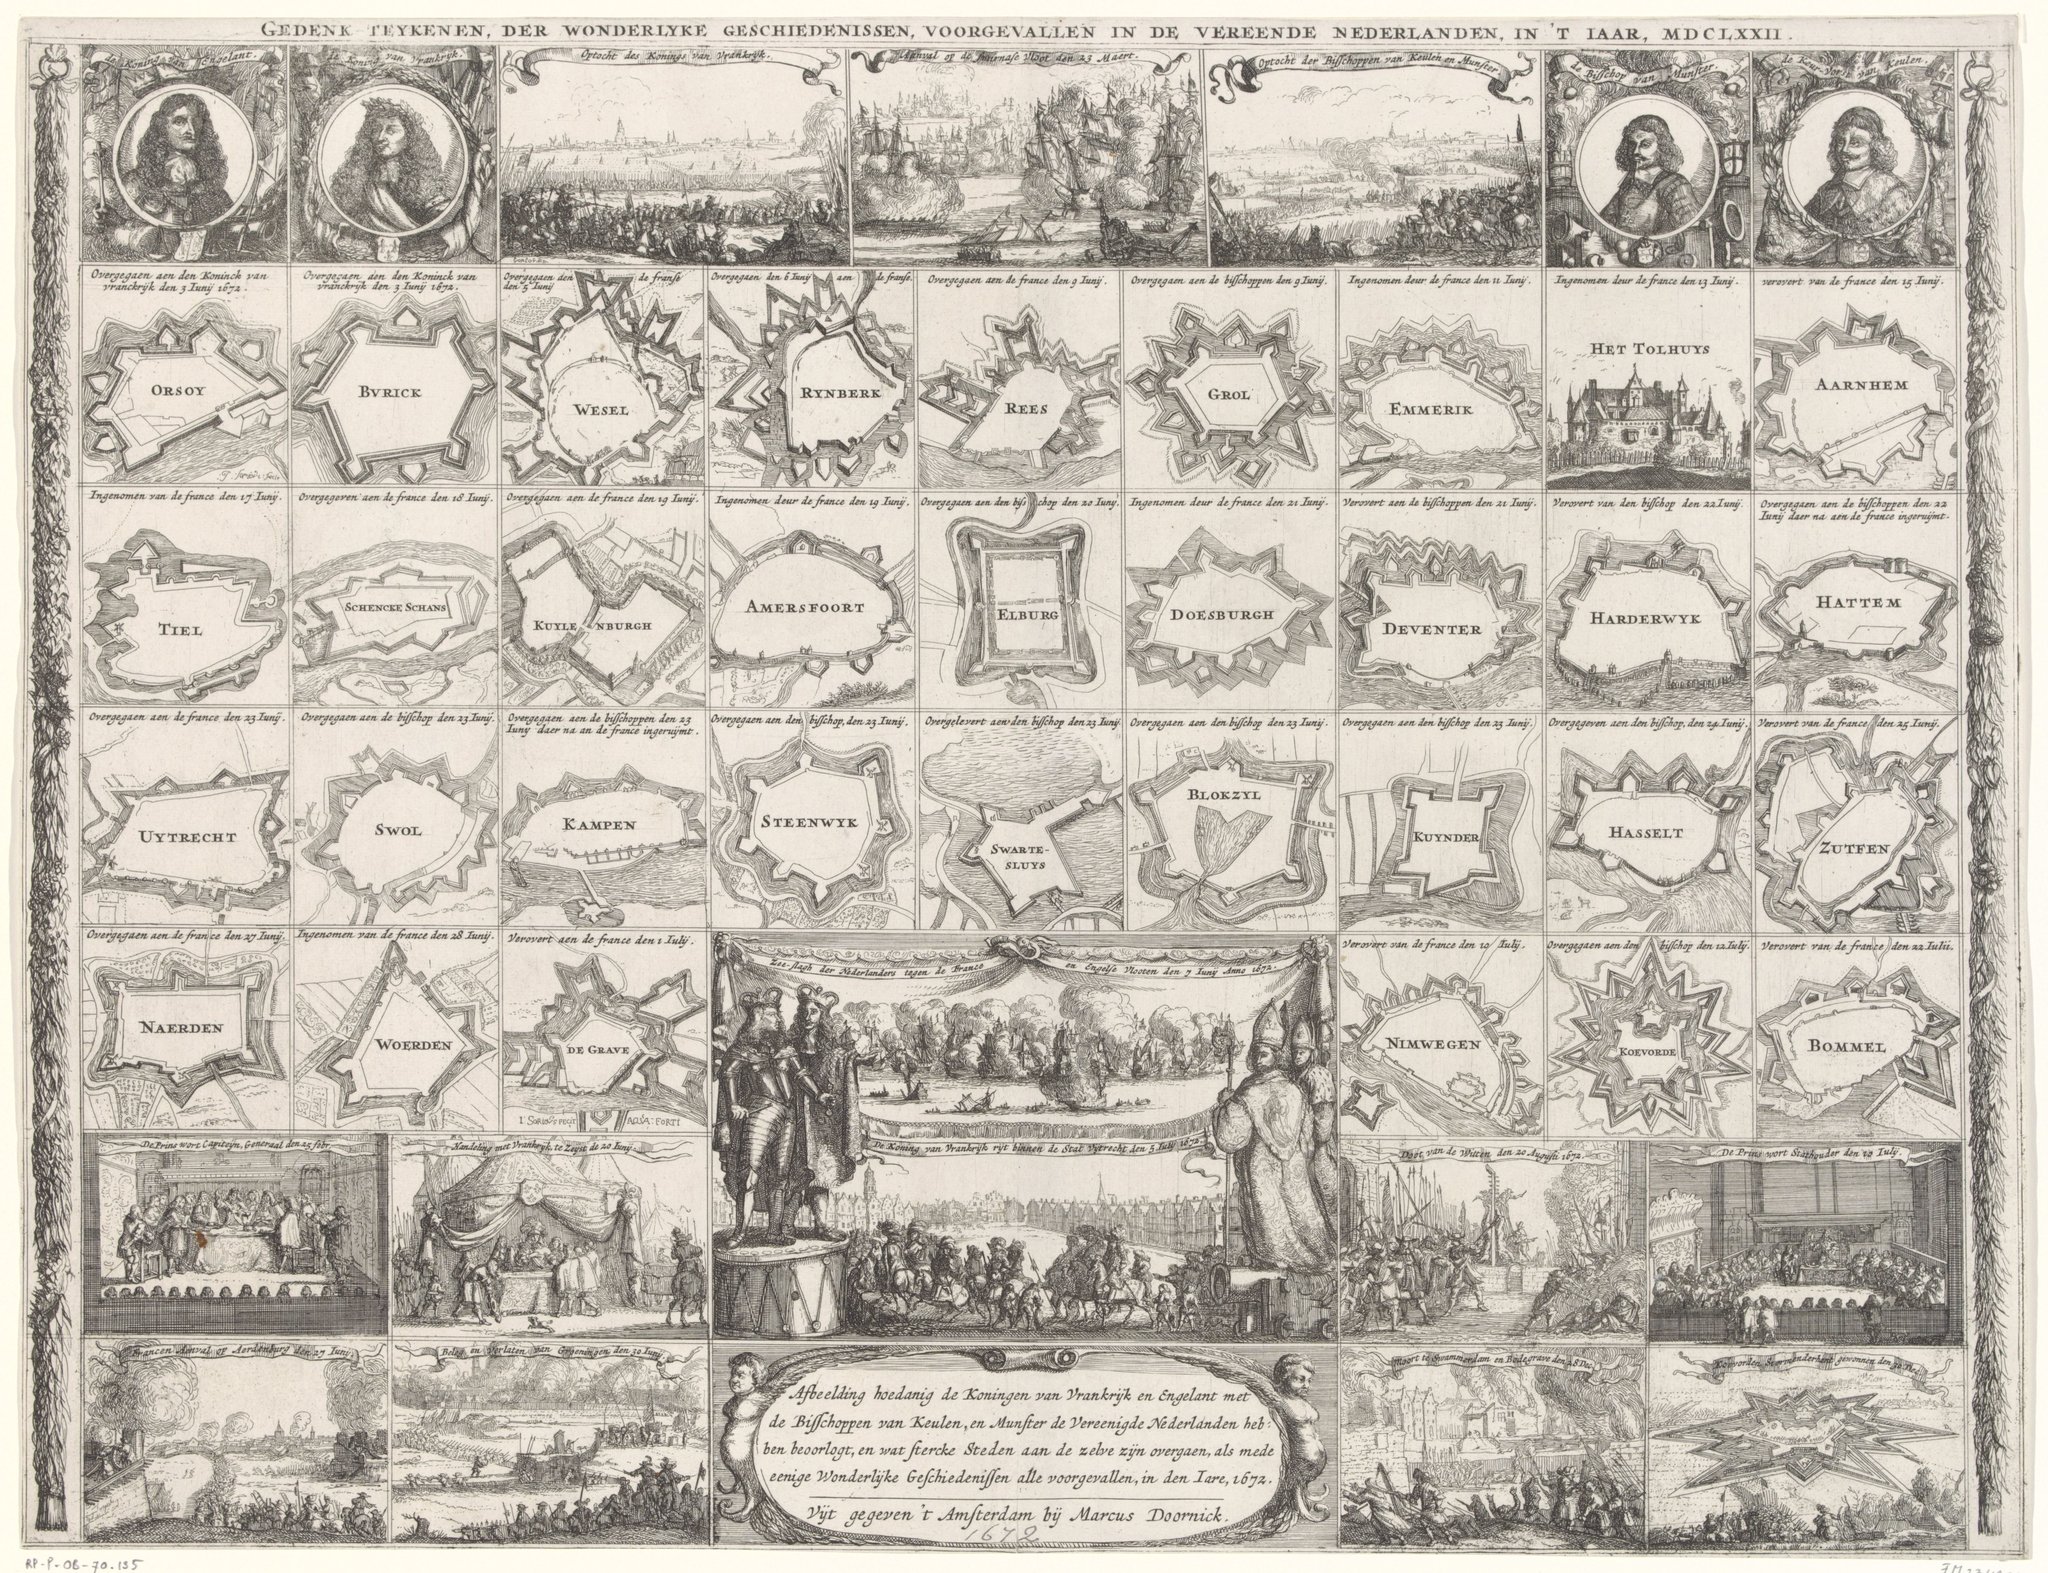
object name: print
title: Overzicht van aan de Fransen verloren versterkte steden en belangrijke gebeurtenissen van het jaar 1672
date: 1672-1674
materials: paper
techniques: etching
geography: amsterdam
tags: lodewijk xiv (koning van frankrijk), maximiliaan hendrik van beieren, london, karel ii (koning van engeland), fortress, utrecht, deventer, nijmegen, grave, arnhem, rampjaar (disaster year)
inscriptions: collector's mark: Lugt 2228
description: Prent met een overzicht van verschillende gebeurtenissen voorgevallen in 1672 en alle steden, vestingen en bouwwerken die in dat jaar in de oorlog aan de Engelsen, Fransen en aan de bisschop van Munster zijn verloren.